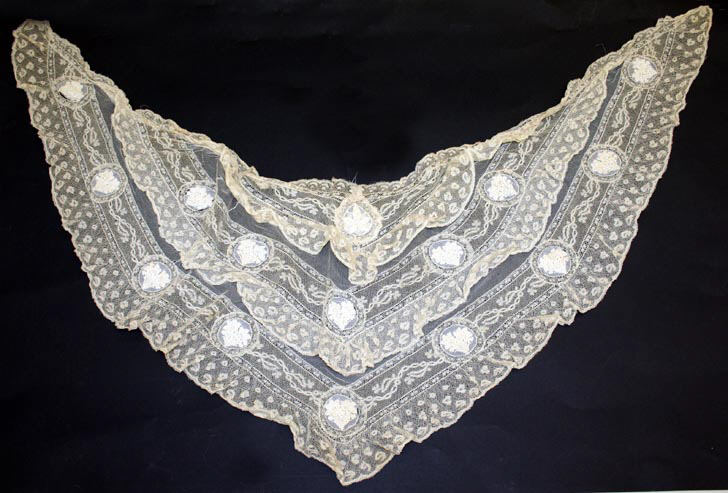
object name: fichu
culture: american or european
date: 1801-1900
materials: cotton